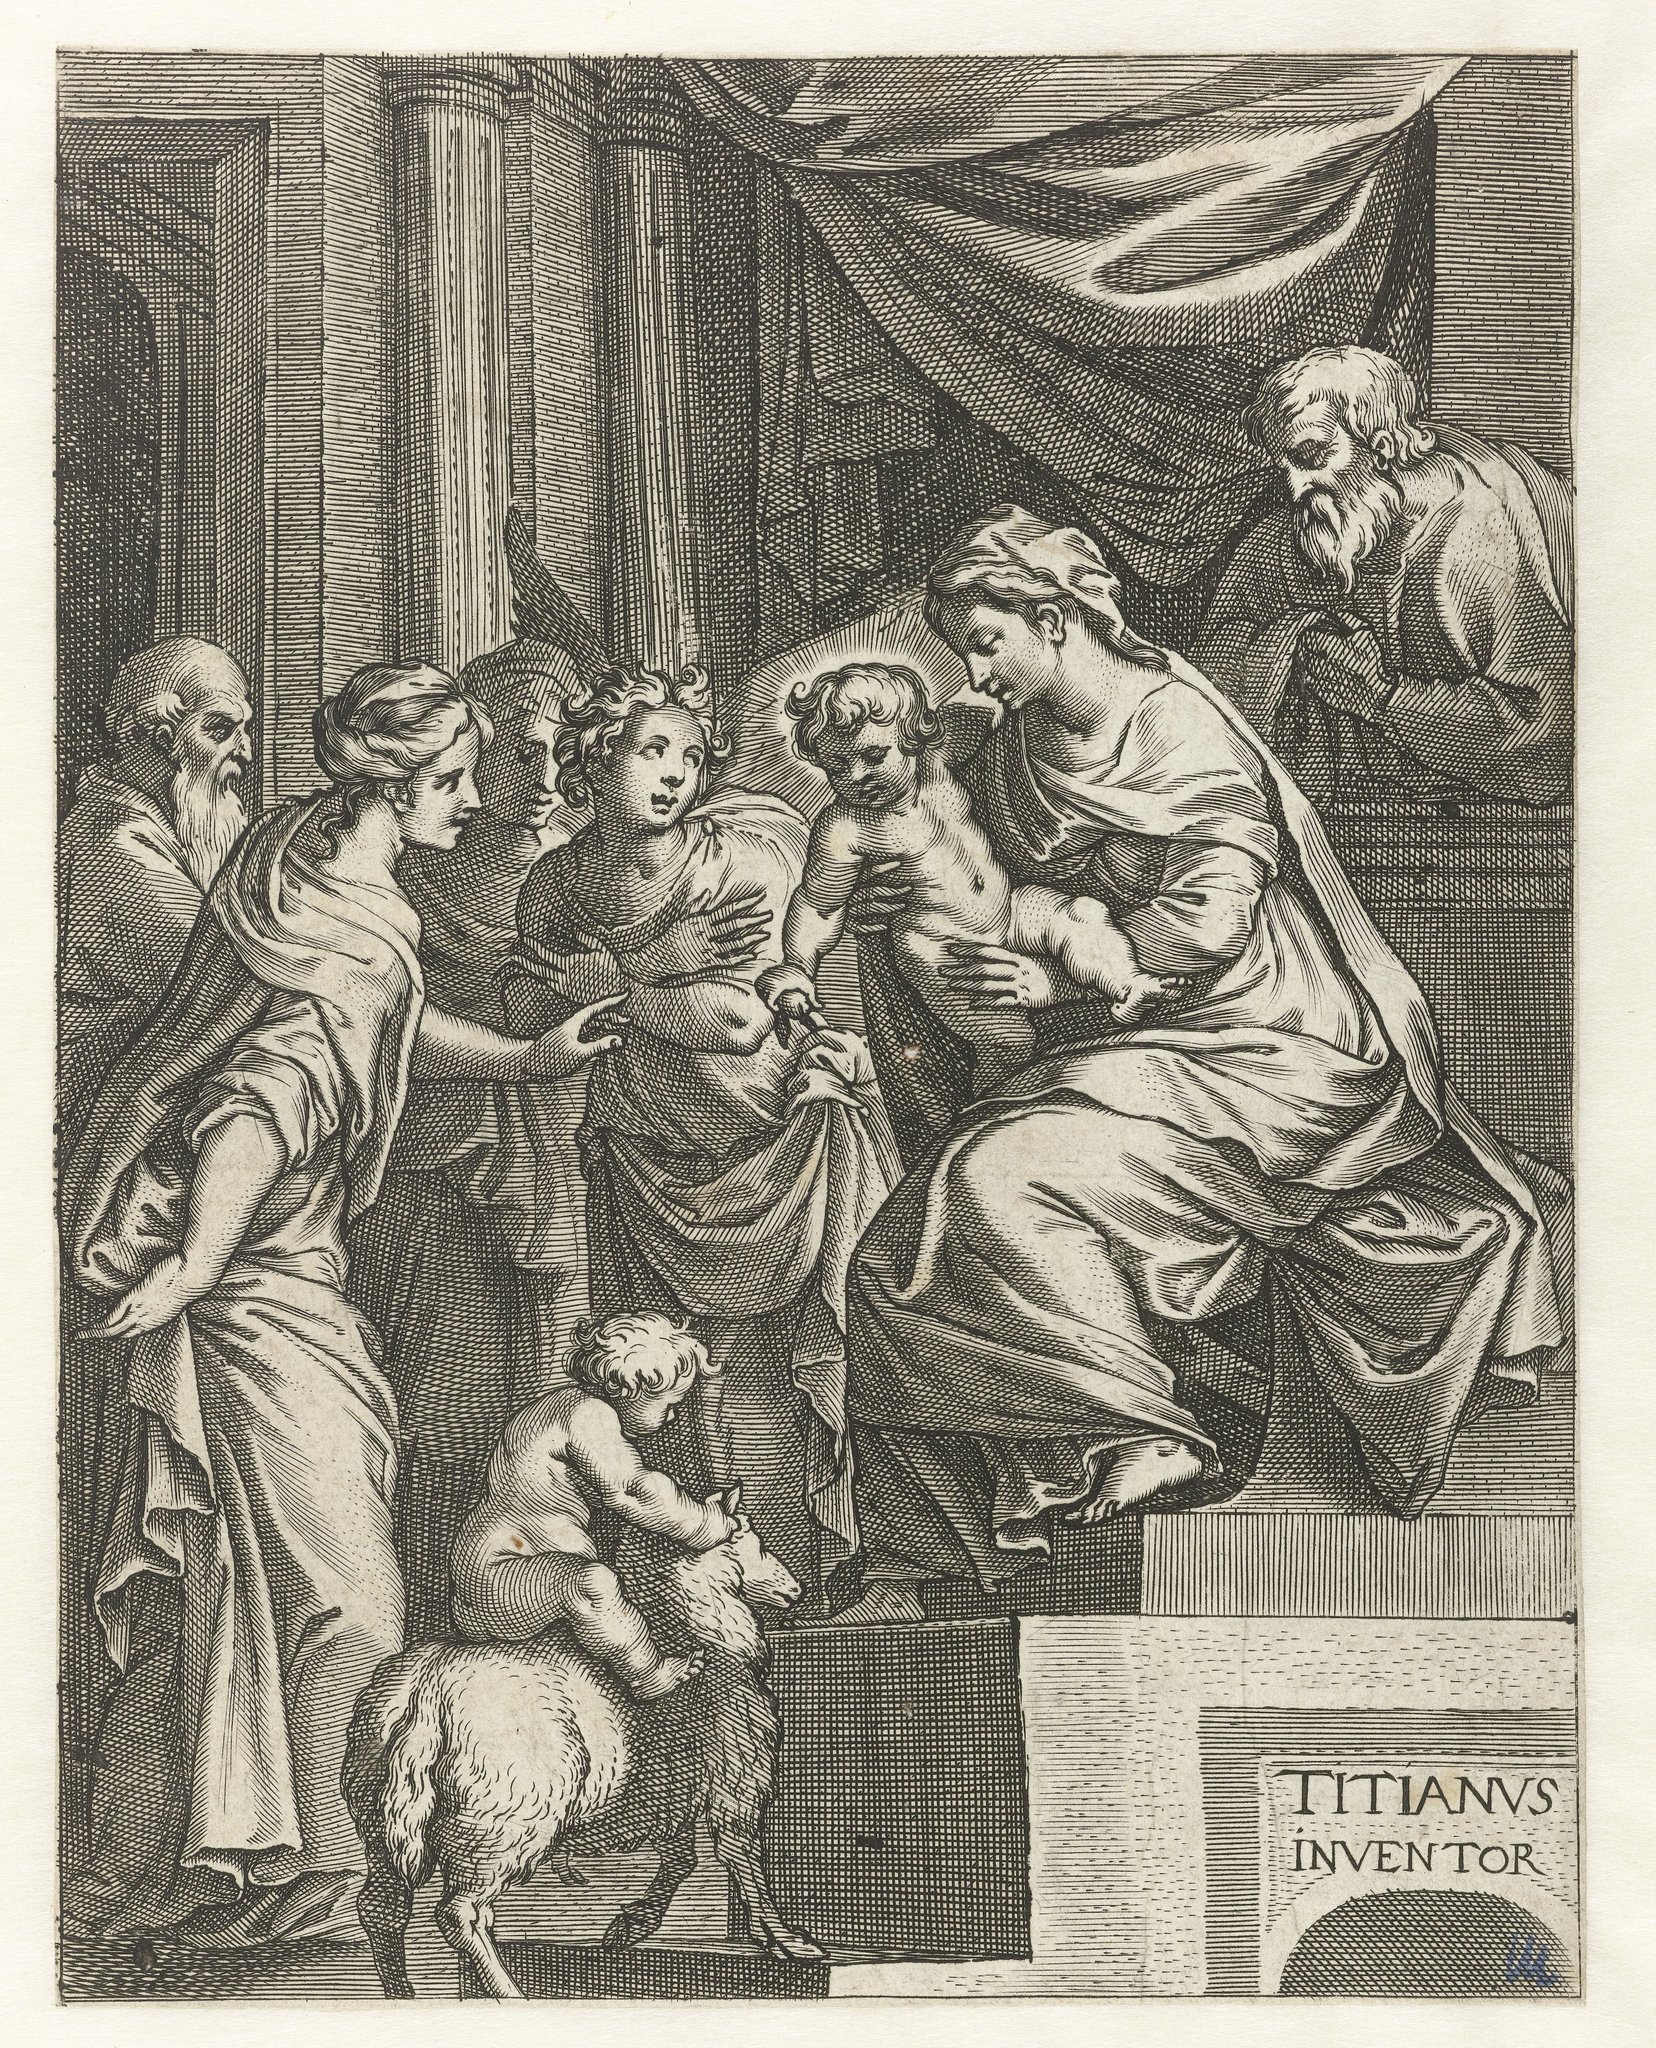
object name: print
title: Heilige Familie met heiligen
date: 1563-1615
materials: paper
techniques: engraving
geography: italy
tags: holy family, and derived representations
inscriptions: collector's mark: Lugt 2228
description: Rechts zit Maria op een troon met in haar armen het Christuskind dat een appel in de hand heeft. Achter haar staat Jozef. Voor de troon staan twee vrouwen, een engel en een oude man. Op de voorgrond de kleine Johannes de Doper zittend op een lam. Op de achtergrond pilaren en een draperie.